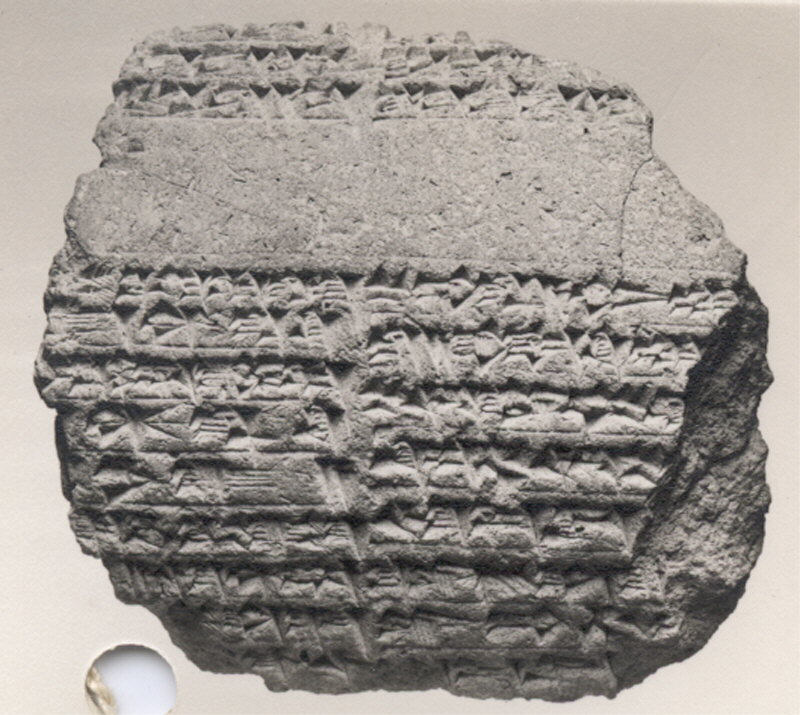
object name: cuneiform cylinder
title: Cuneiform cylinder: inscription of Nebuchadnezzar II commemorating the reconstruction of Etemenanki, the ziggurat at Babylon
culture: babylonian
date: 604-562 BCE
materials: clay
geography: mesopotamia